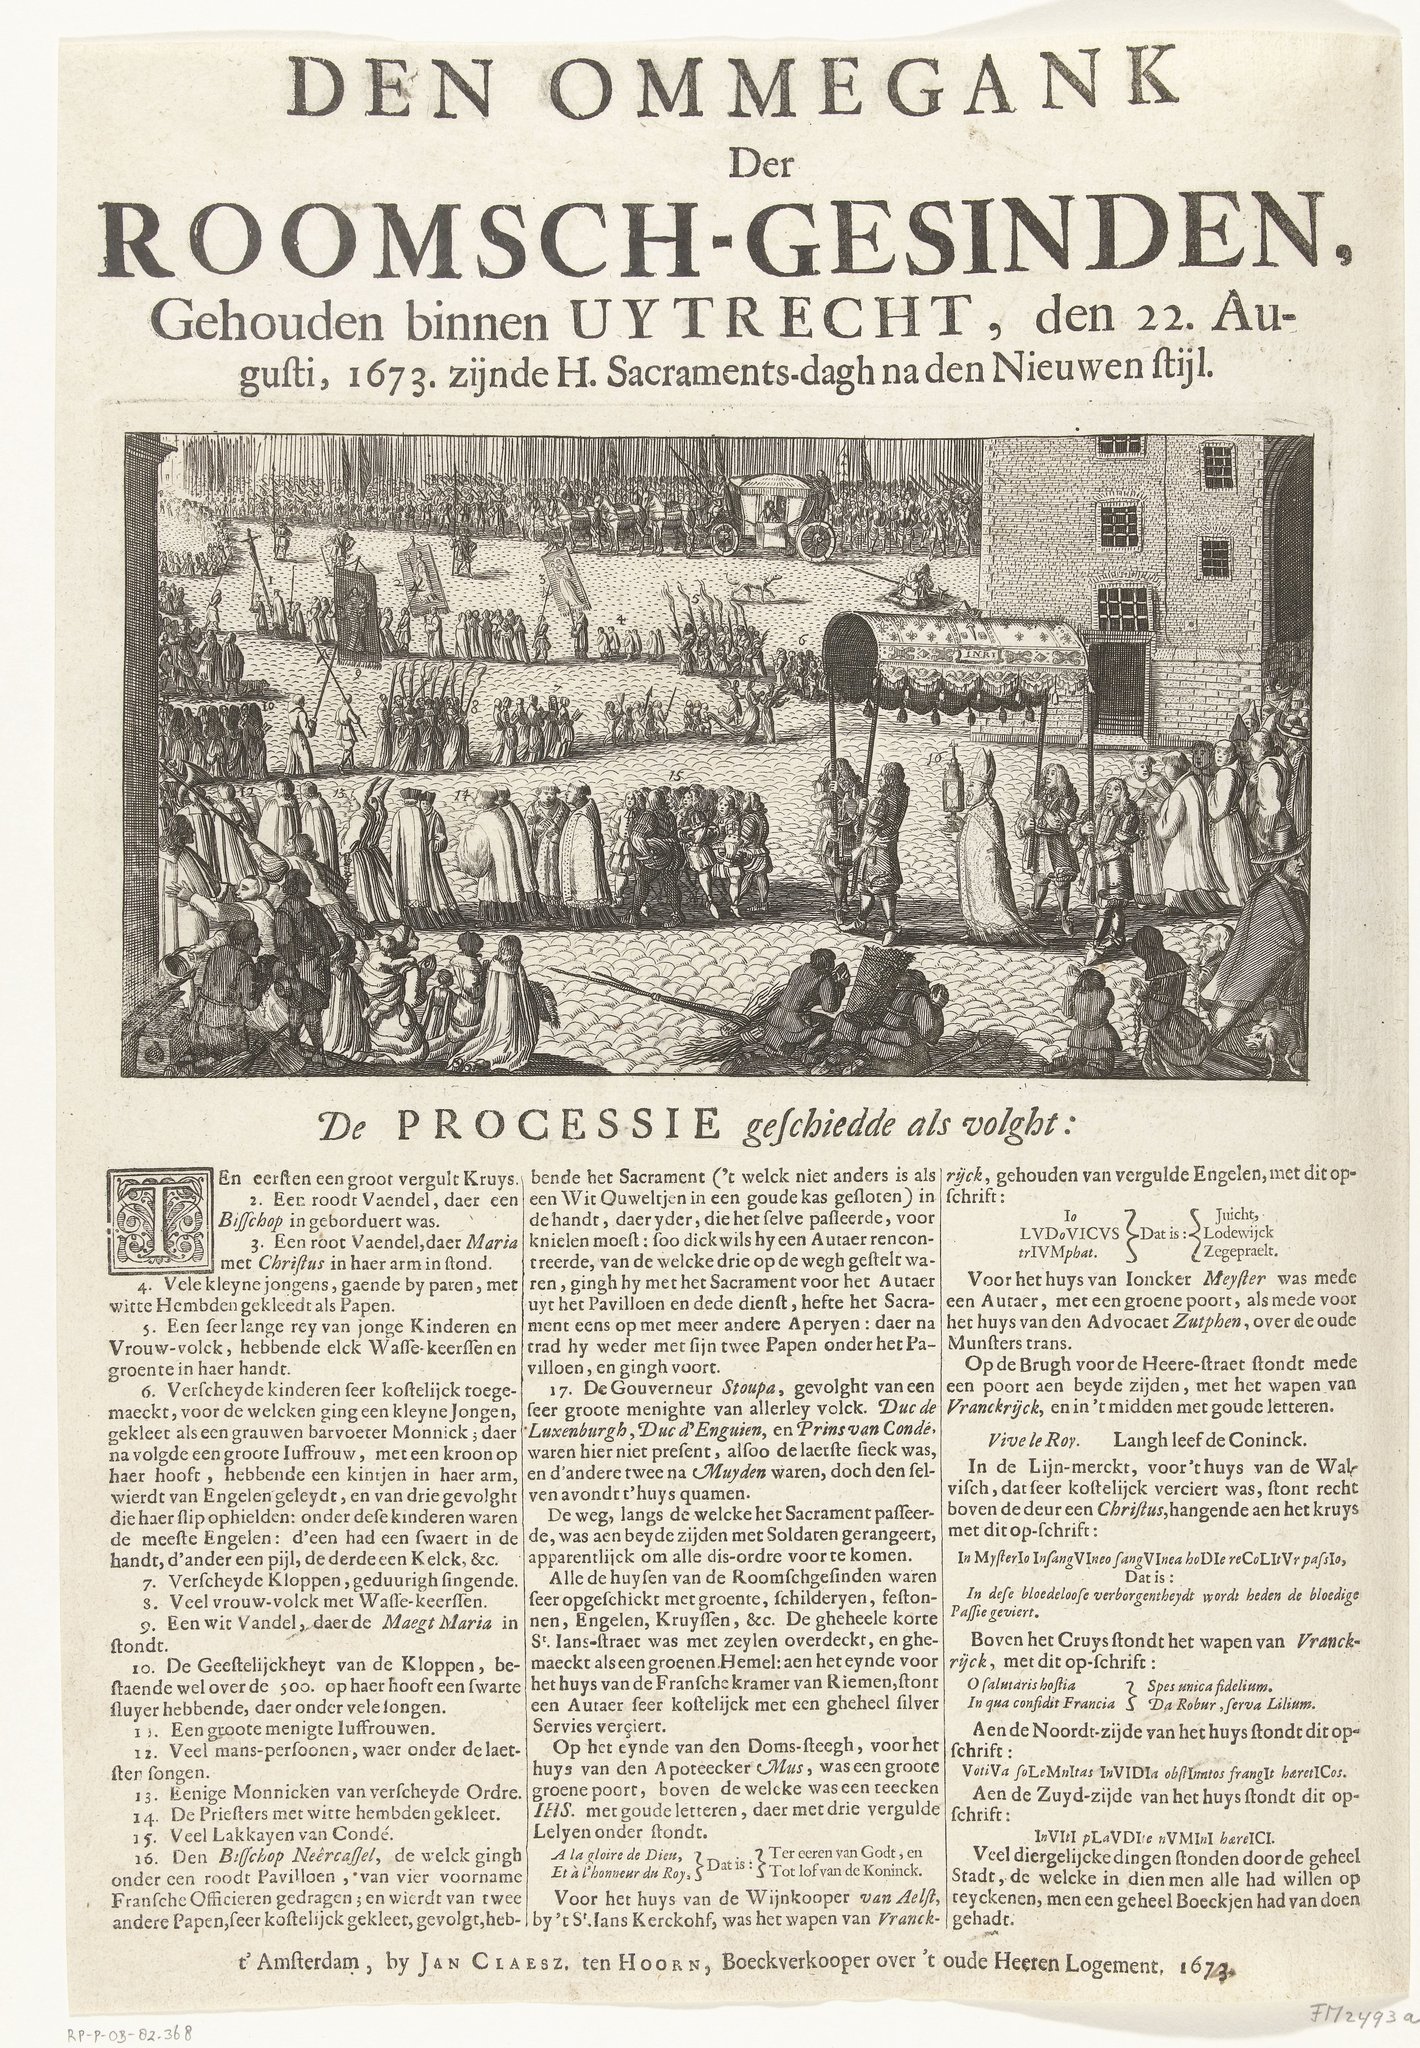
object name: print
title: Roomse processie te Utrecht, 1673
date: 1673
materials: paper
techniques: etching, letterpress printing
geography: northern netherlands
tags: procession ~ christian religion, battle of the texel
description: Roomse sacramentsprocessie gehouden te Utrecht op Sacramentsdag, 22 augustus 1673 (een verzonnen datum, wellicht verwijzend naar de overwinning van de Hollanders in de zeeslag bij Kijkduin op 21 augustus 1673). De stoet bij de ingang tot de Domtoren met de bisschop (eigenlijk Apostolisch Vicaris van de Hollandse Zending) Johannes van Neercassel onder een baldakijn met de monstrans het sacrament. Onder de plaat een tekst in 3 kolommen waarin de gebeurtenis beschreven en belachelijk gemaakt wordt